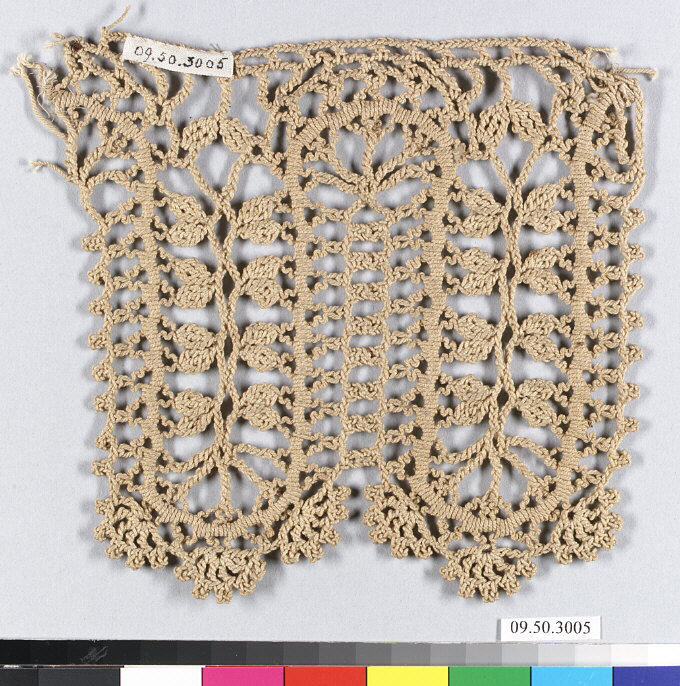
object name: piece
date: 1801-1900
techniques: crochet